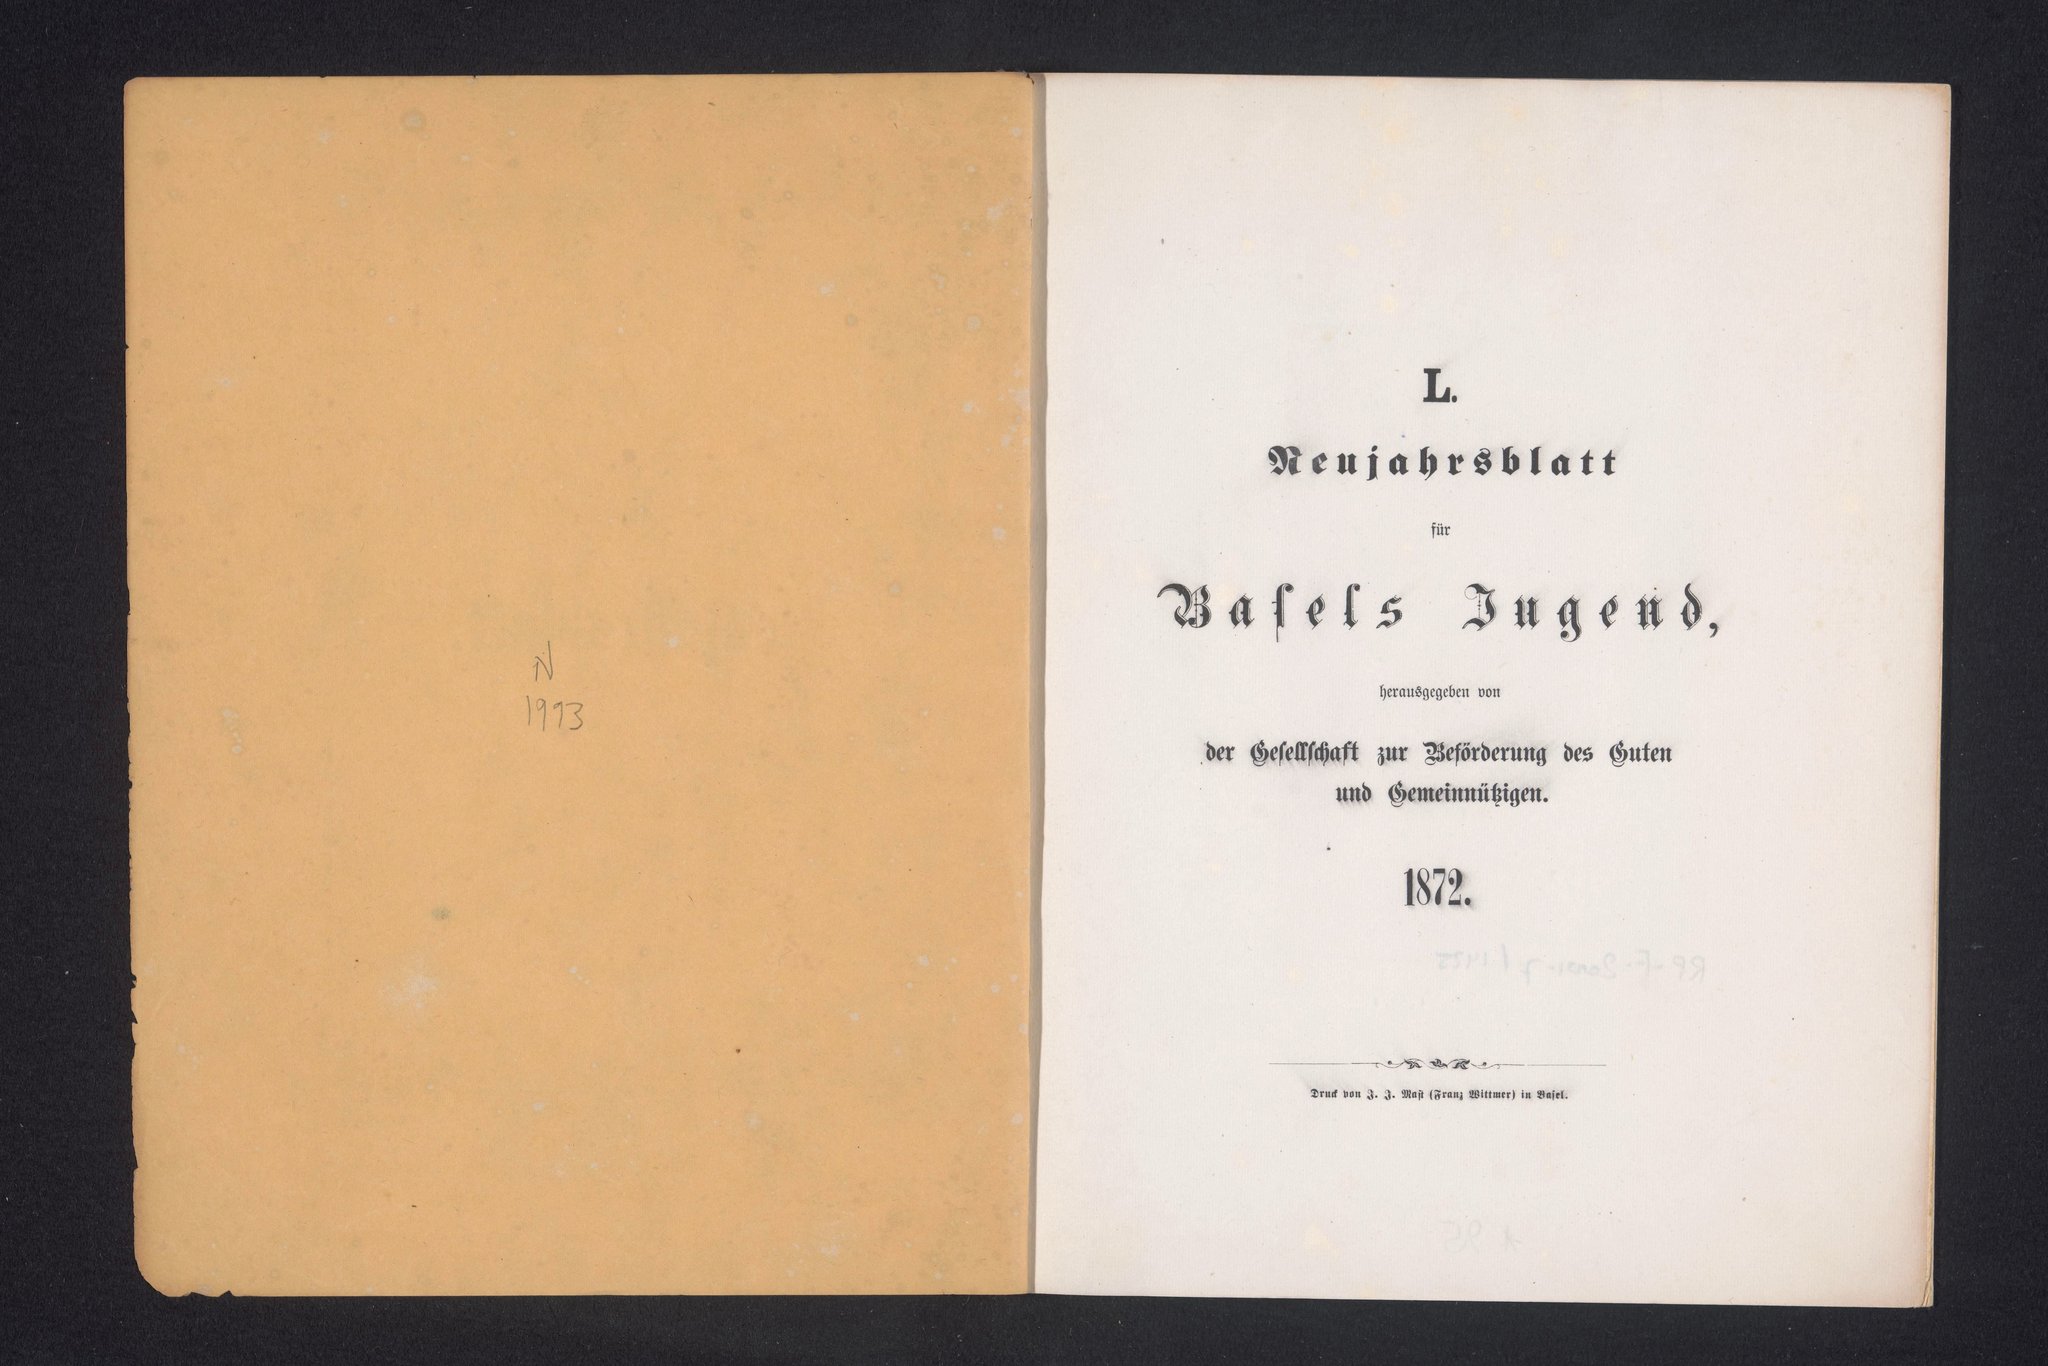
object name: magazine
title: Neujahrsblatt für Basels Jugend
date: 1872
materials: paper, photographic support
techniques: albumen print